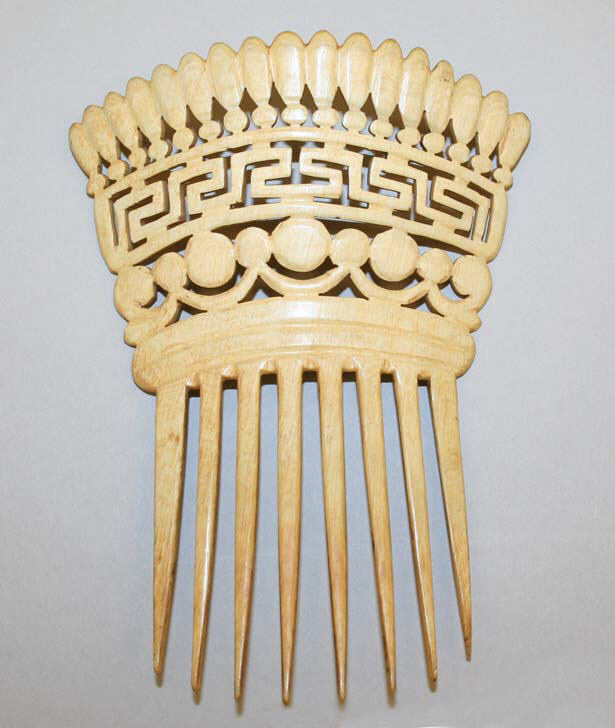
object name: comb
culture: european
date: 1799-1820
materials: bone